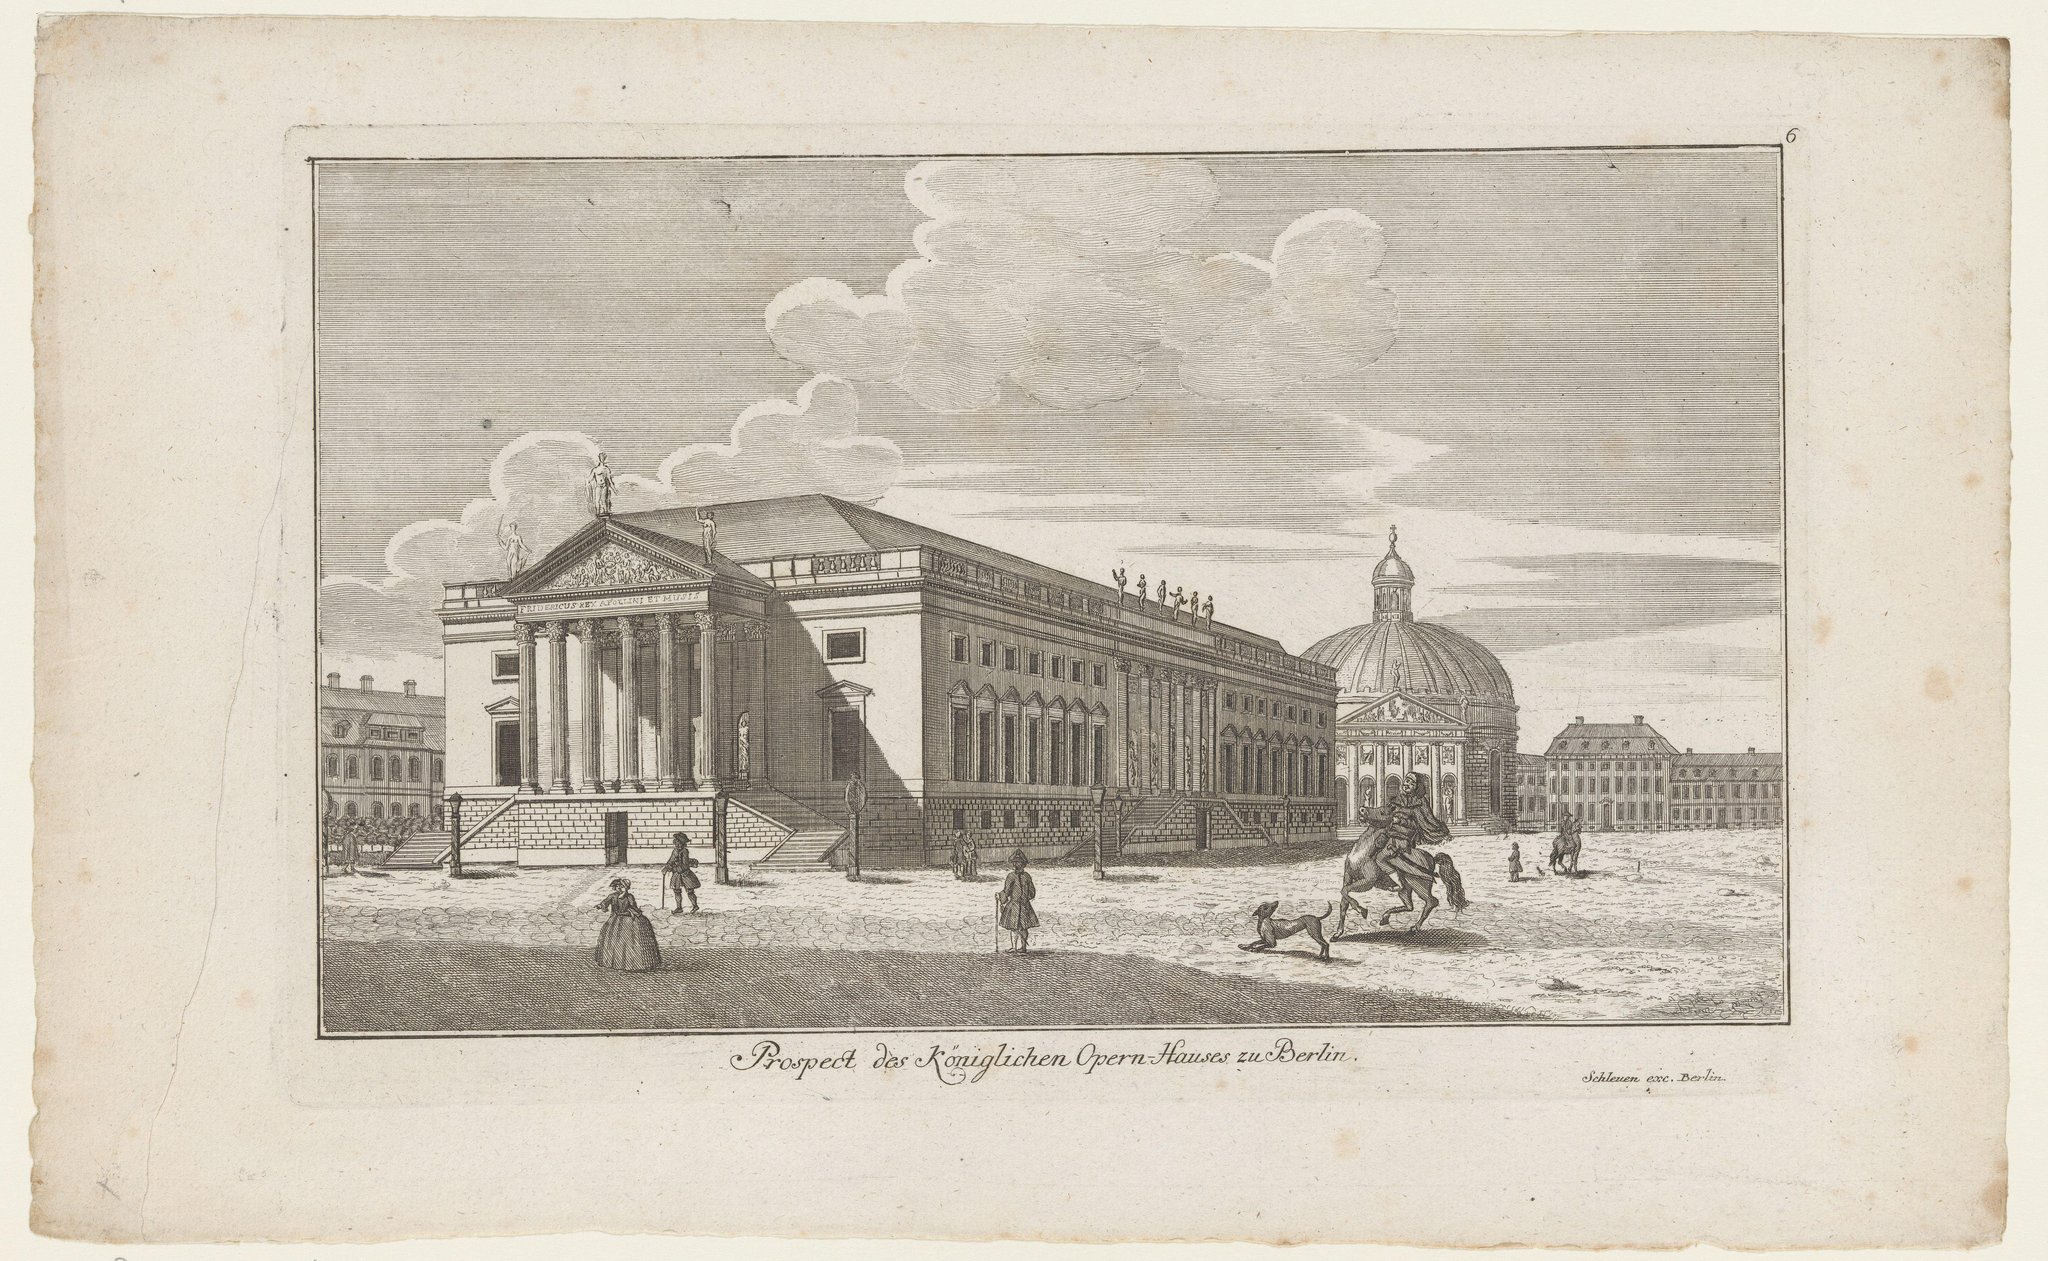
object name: print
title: Prospect des Königlichen Opern-Hauses zu Berlin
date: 1740-1774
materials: paper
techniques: engraving, etching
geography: berlin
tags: opera house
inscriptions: collector's mark: Lugt 2228